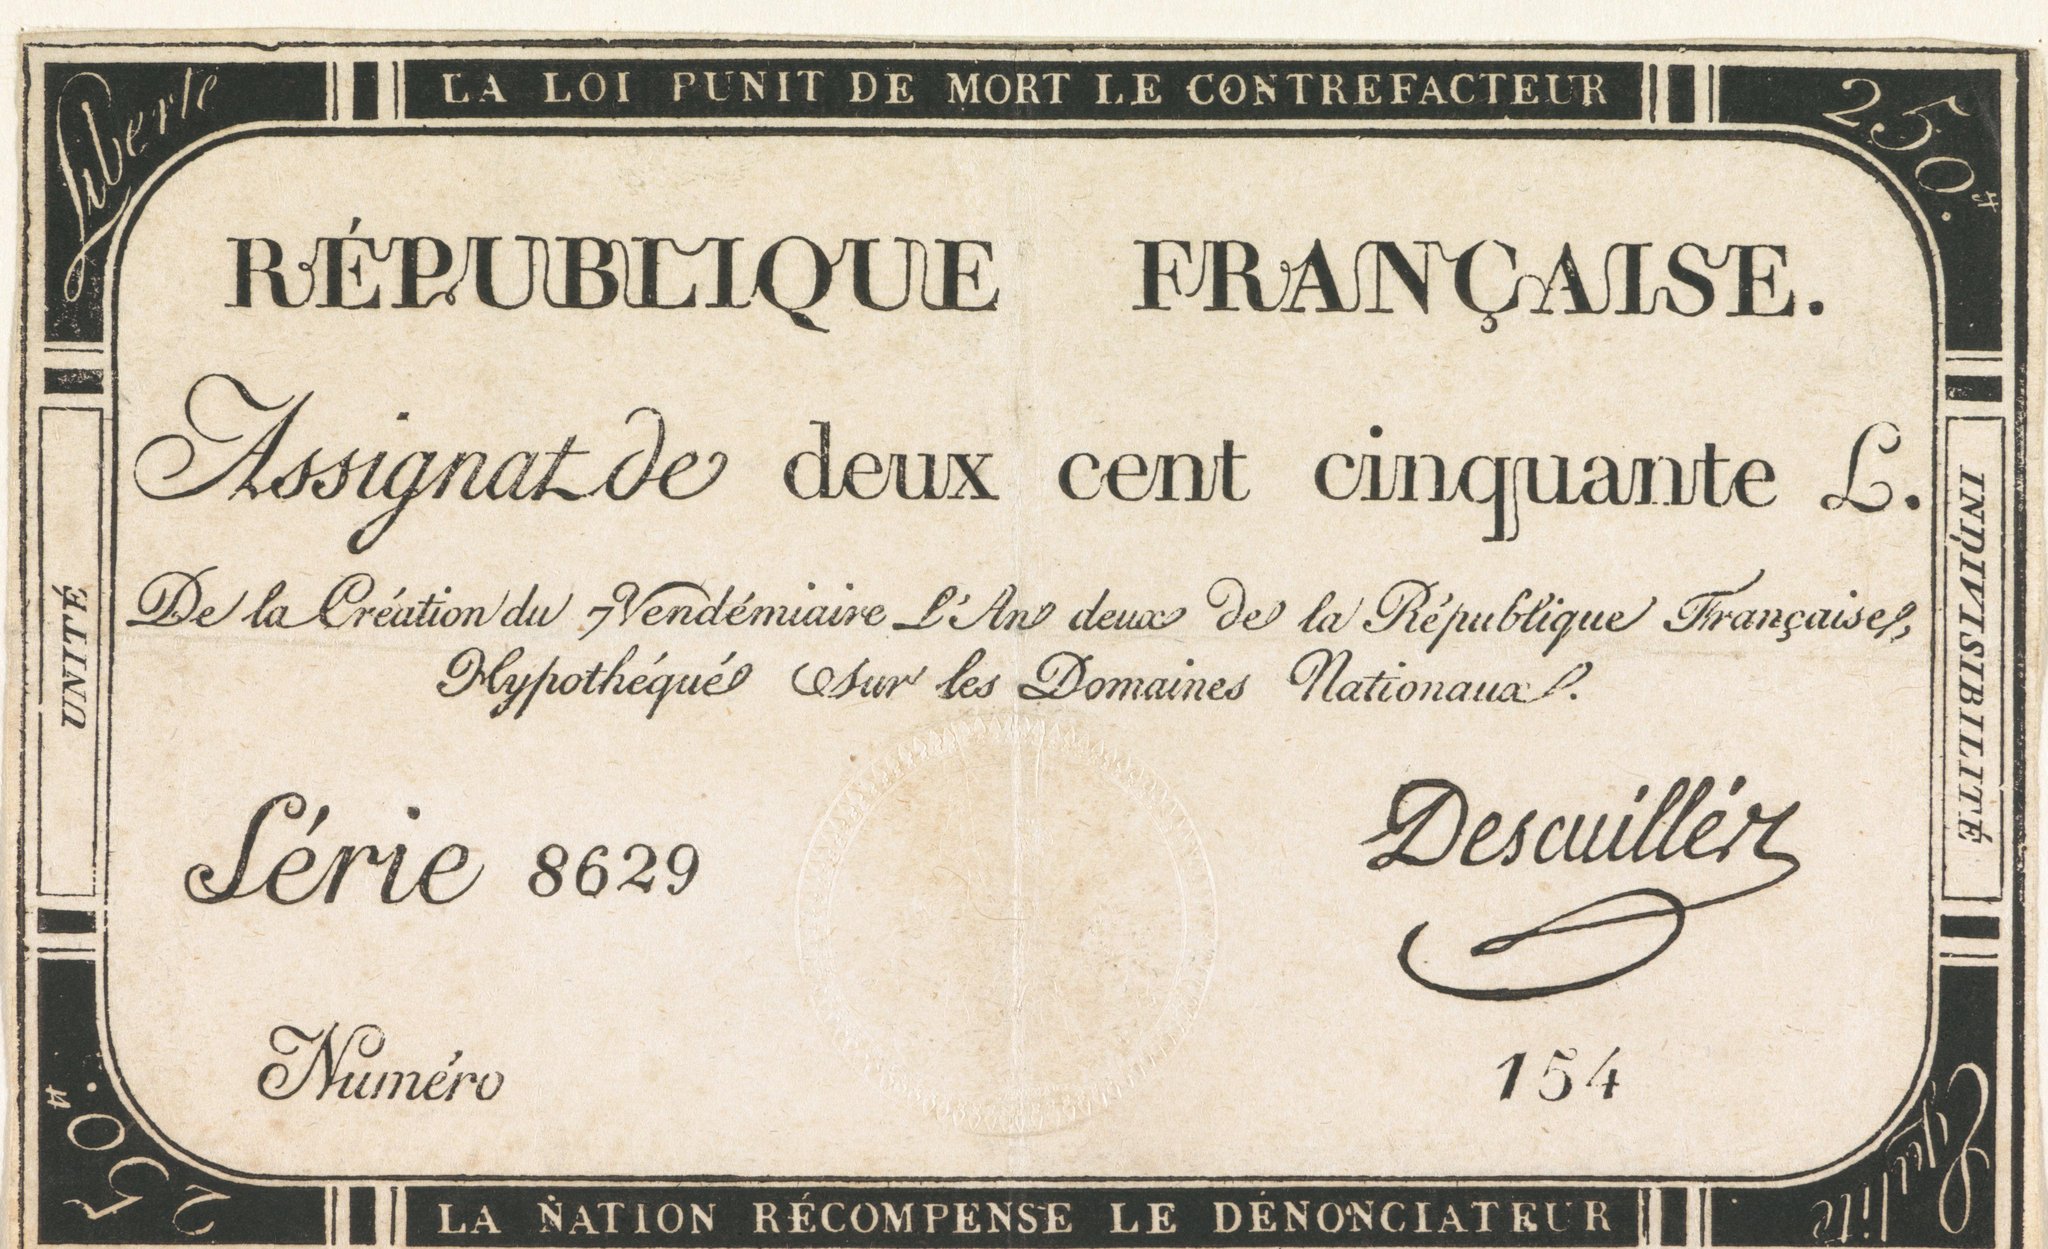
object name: assignat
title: Assignaat van 250 livres, 1793-1794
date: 1793-1794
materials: paper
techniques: blind stamped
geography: france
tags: bank-note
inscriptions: collector's mark: Lugt 2228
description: Assignaat van 250 livres. In omloop gebracht door de Domaines nationaux, serie 8629, 1793-1794.